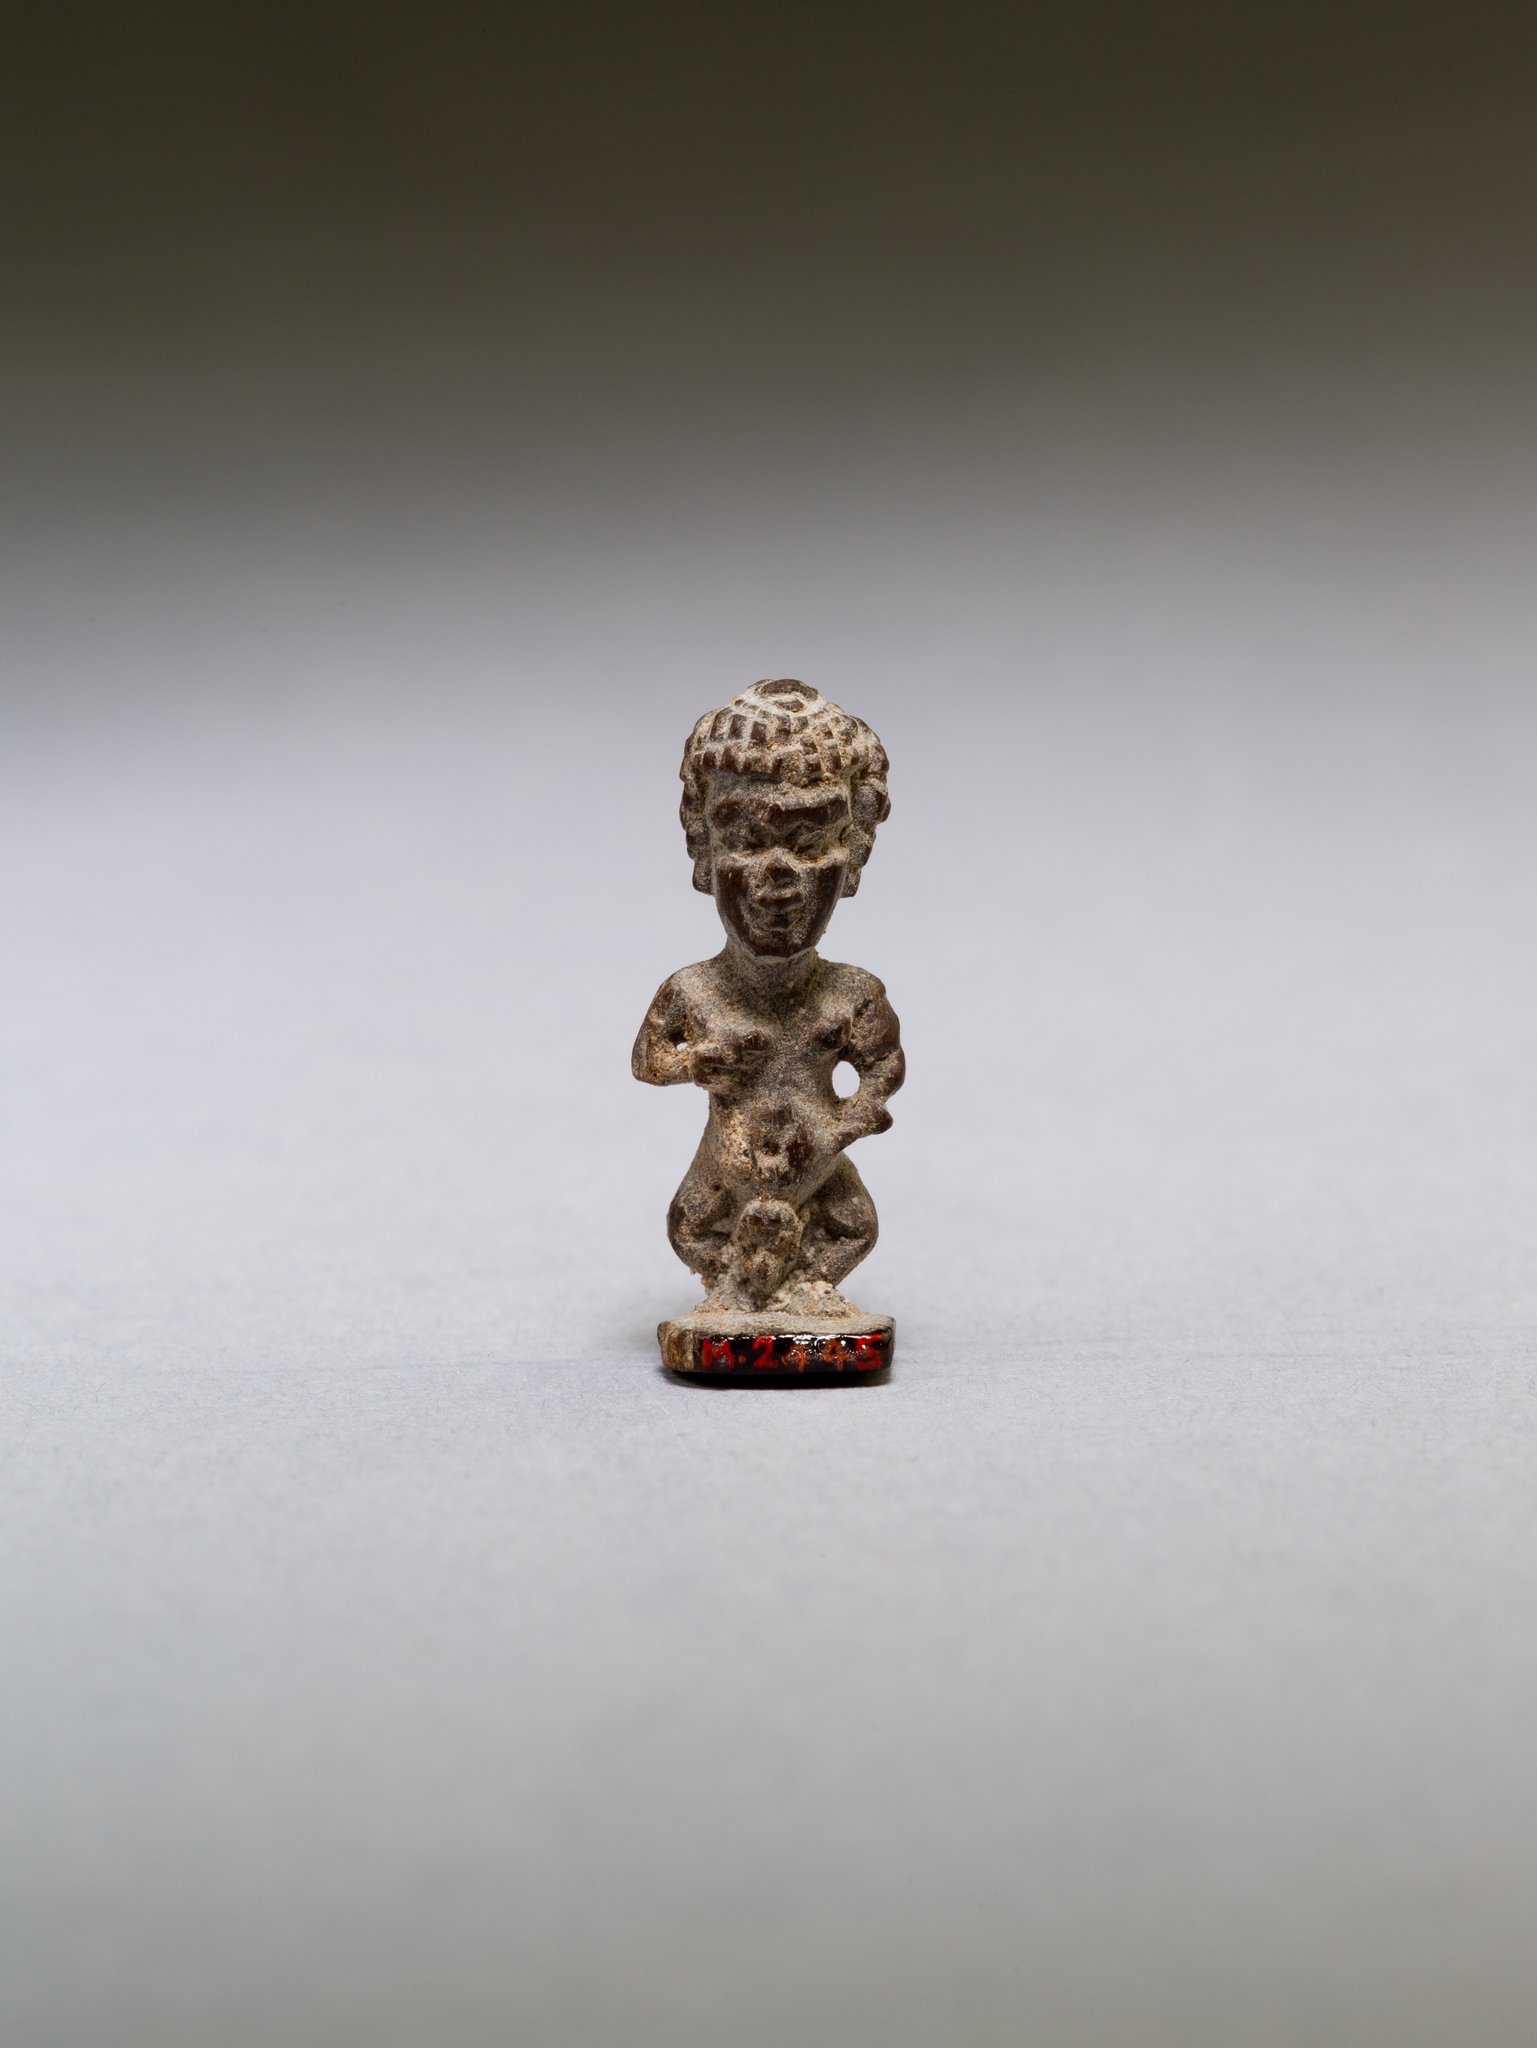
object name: figurine, patiakos, dwarf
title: Pataikos or other dwarf god, with curly hair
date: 664-630 BCE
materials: wood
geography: egypt